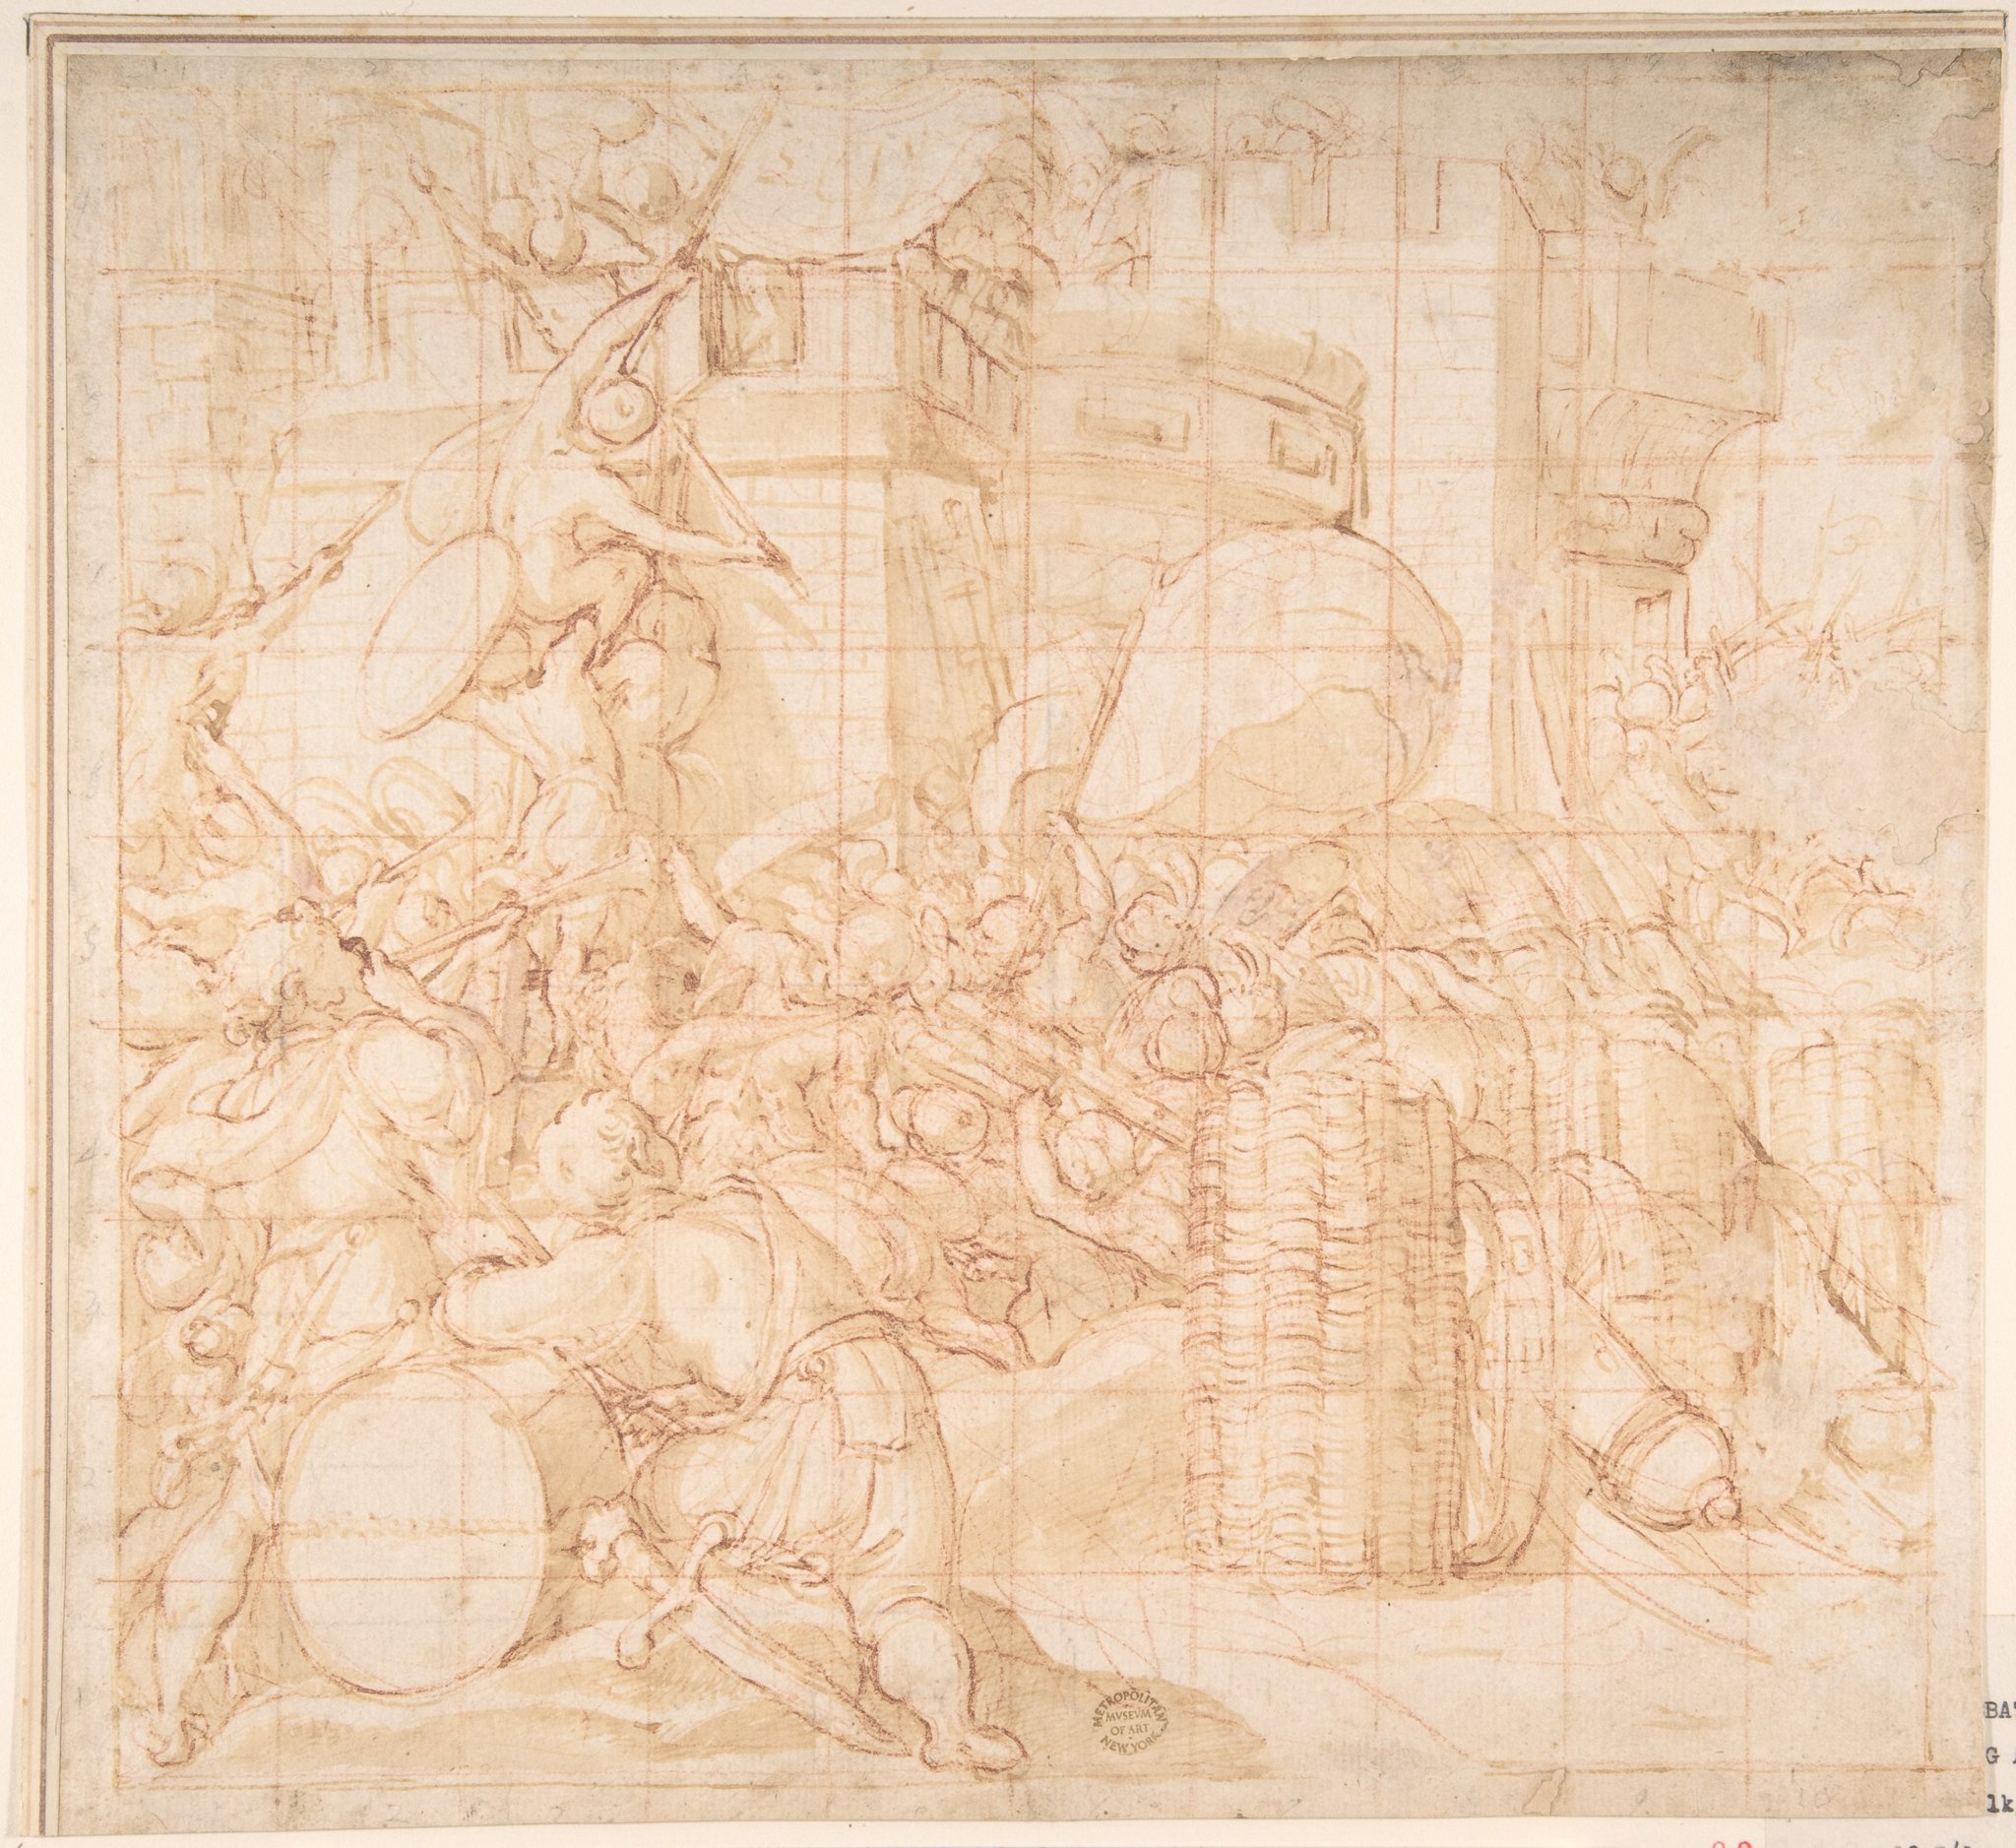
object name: drawing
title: Storming a City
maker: anonymous, italian, 16th century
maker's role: artist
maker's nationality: italian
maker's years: 1550-1600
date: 1501-1600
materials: chalk, ink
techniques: drawing, wash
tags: cities,men,crowd